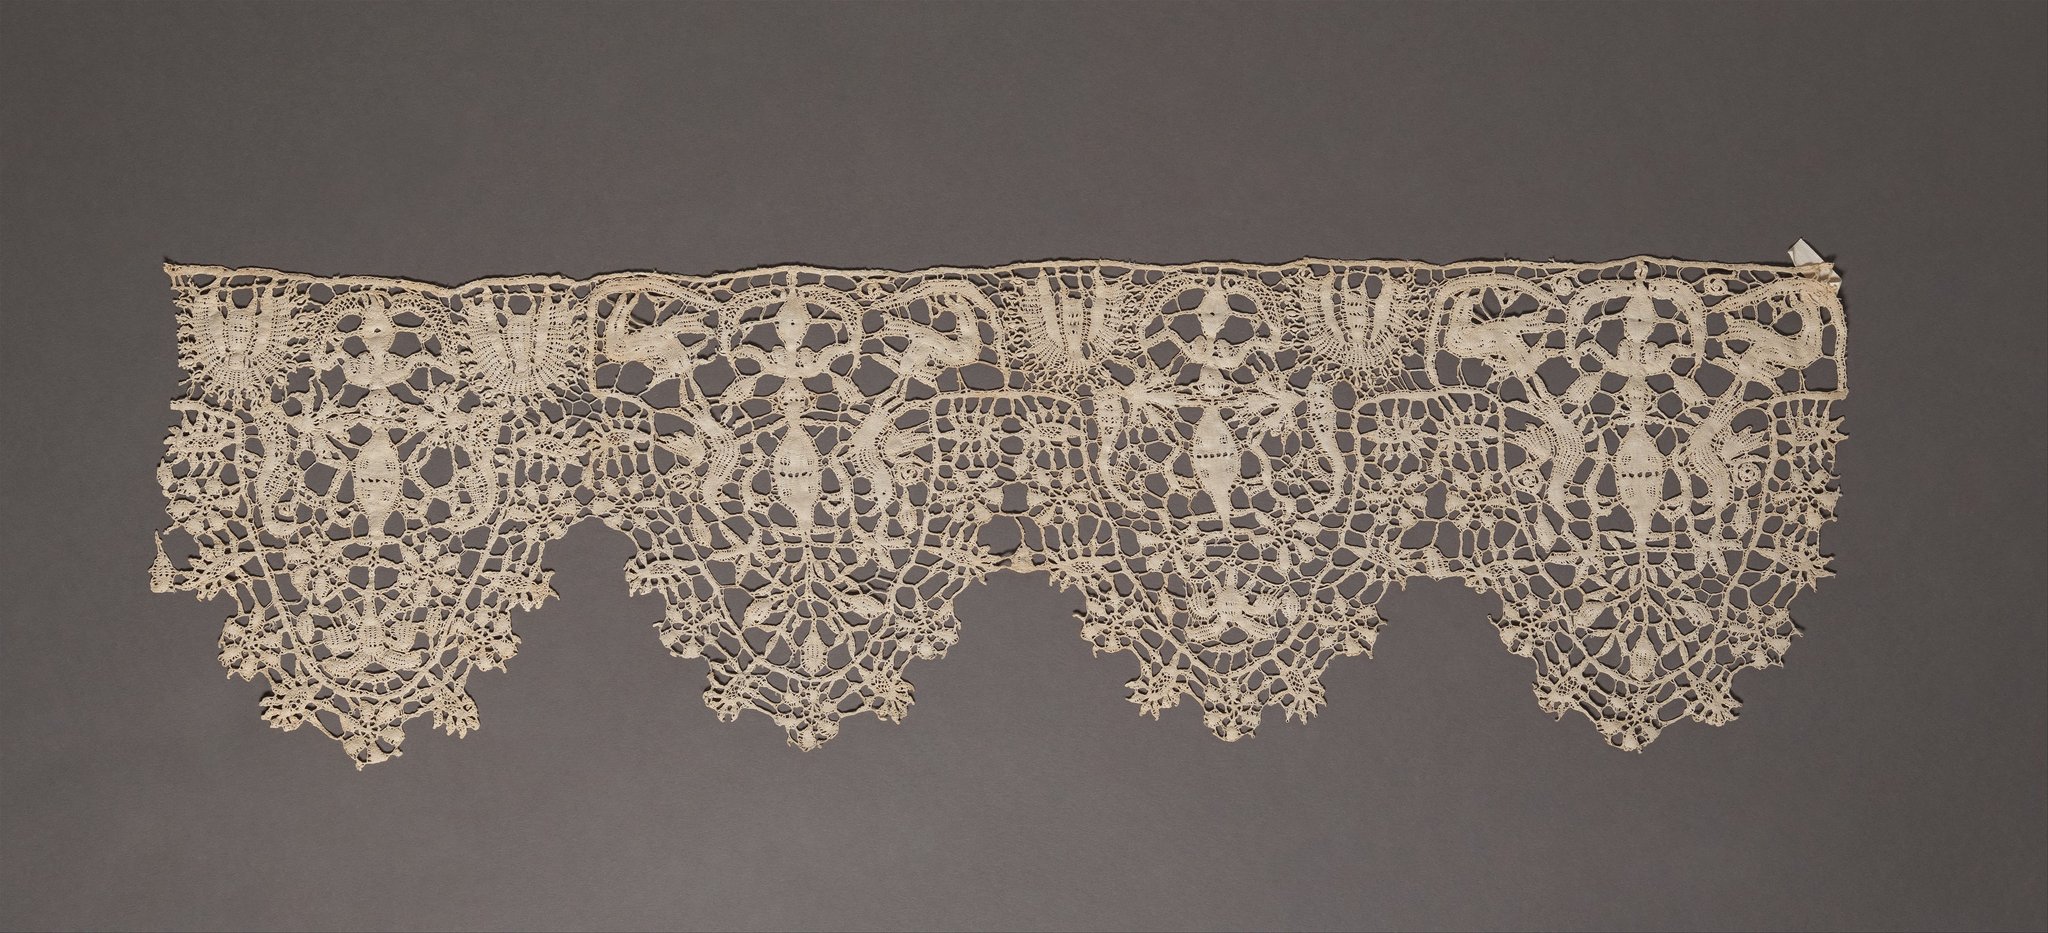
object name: border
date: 1601-1700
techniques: lace